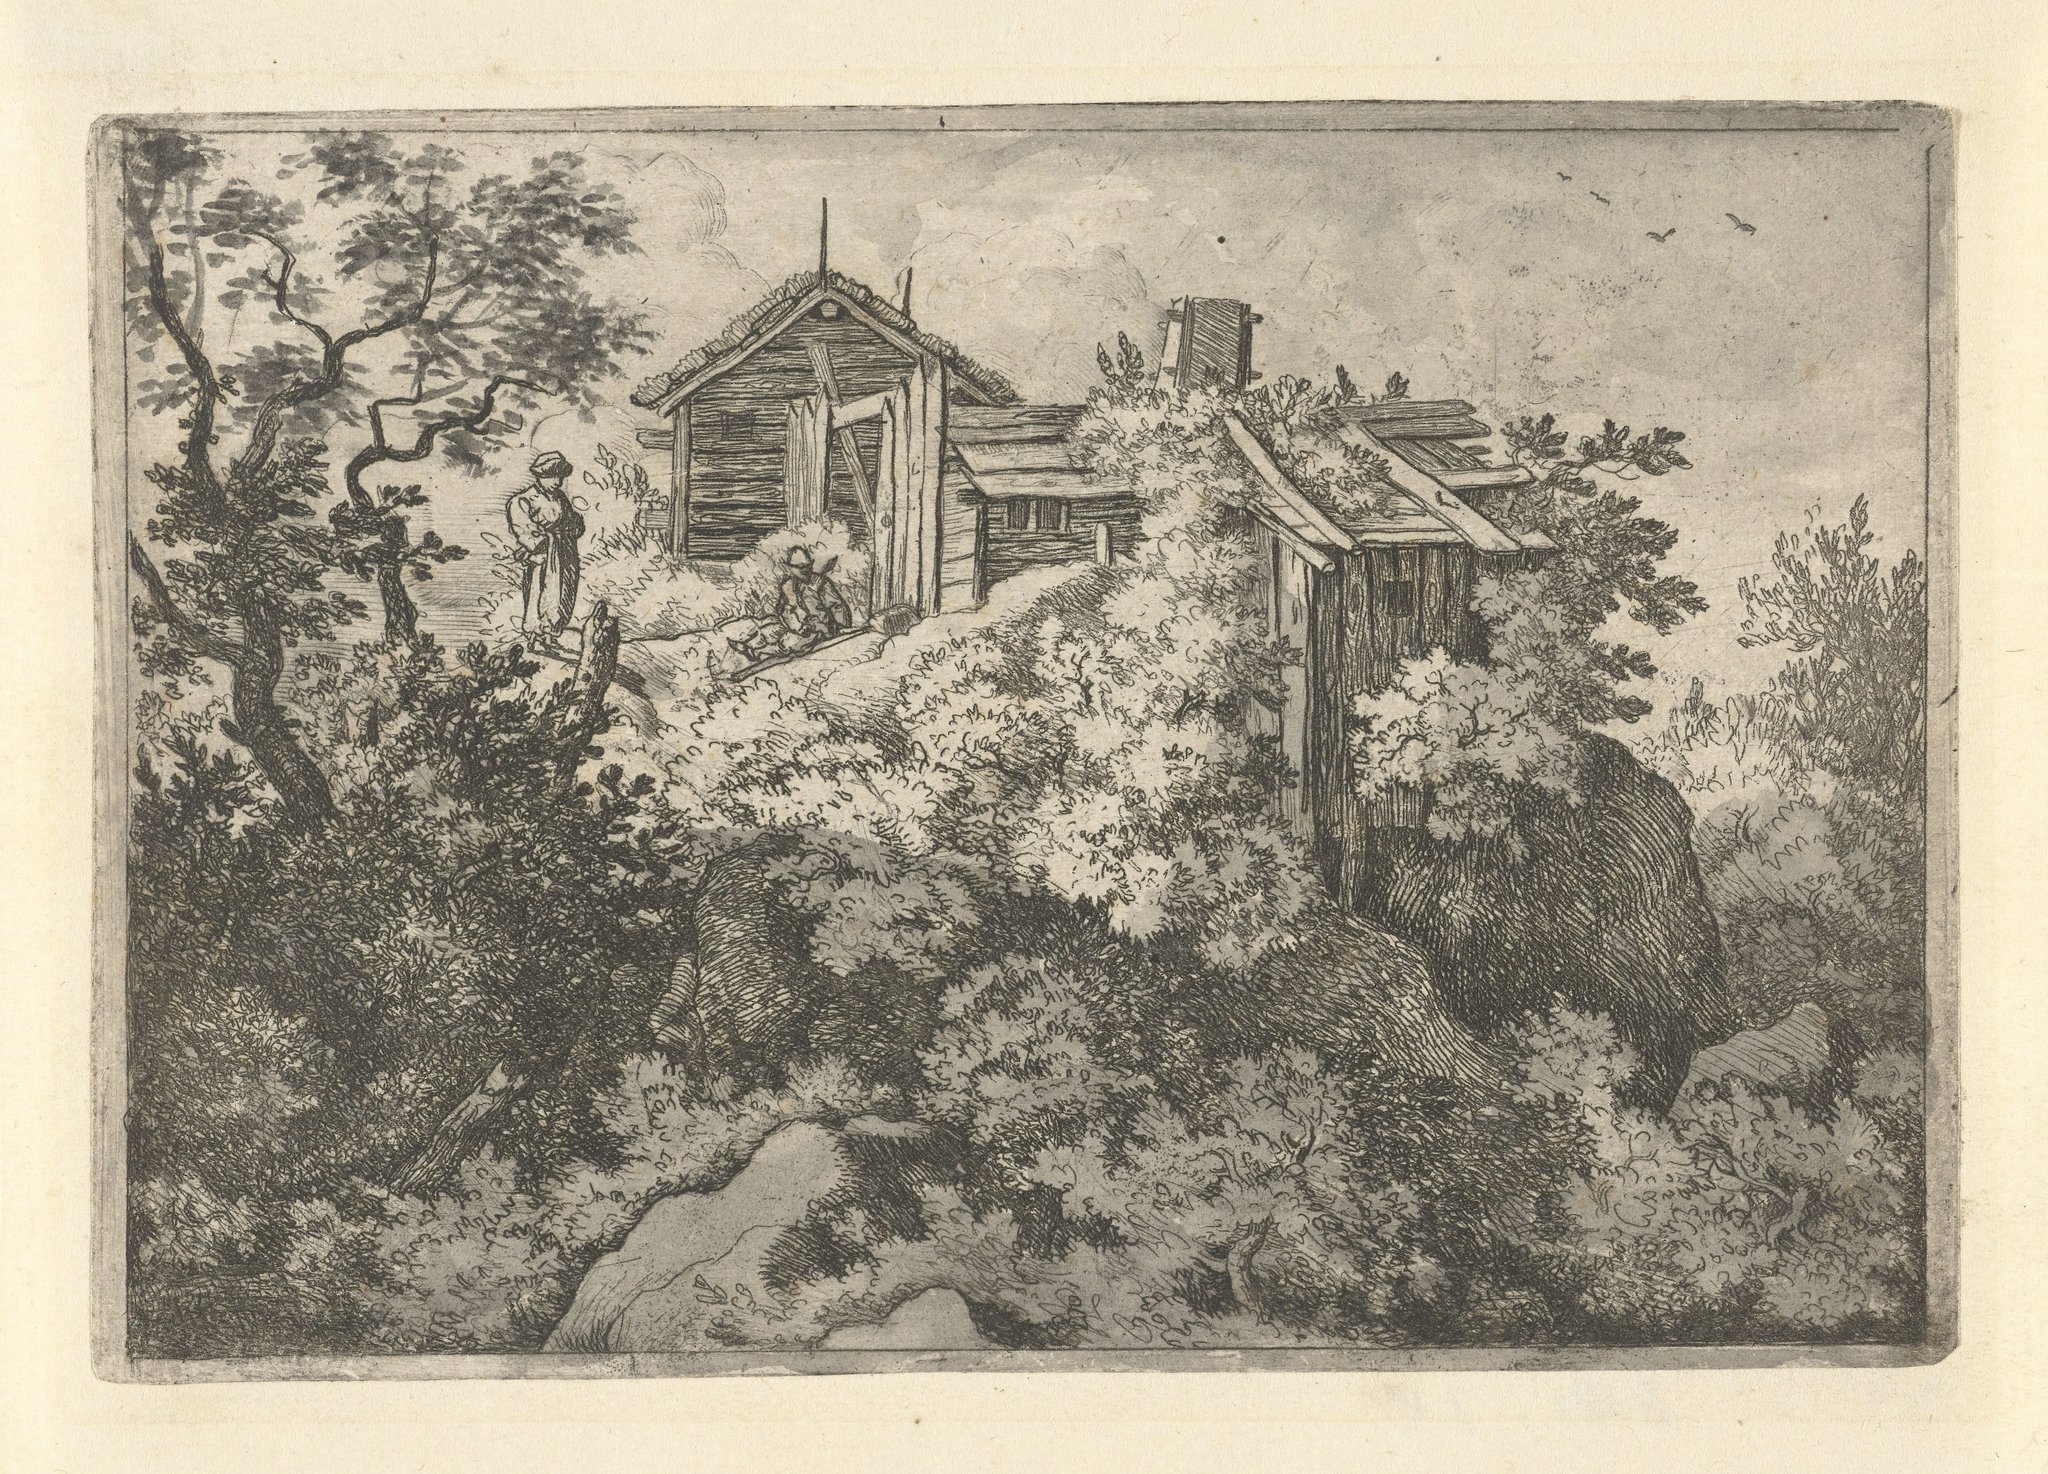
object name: print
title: Drie huizen op een rots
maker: allaert van everdingen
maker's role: draughtsman, painter, print maker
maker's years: 1621-1675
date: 1651-1675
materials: paper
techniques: etching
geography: netherlands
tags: farm or solitary house in landscape (+ city(-scape) with figures, staffage)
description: Gezicht op houten huizen op een rots begroeid met bomen en struikgewas. Op een open plek een staand en zittend persoon.